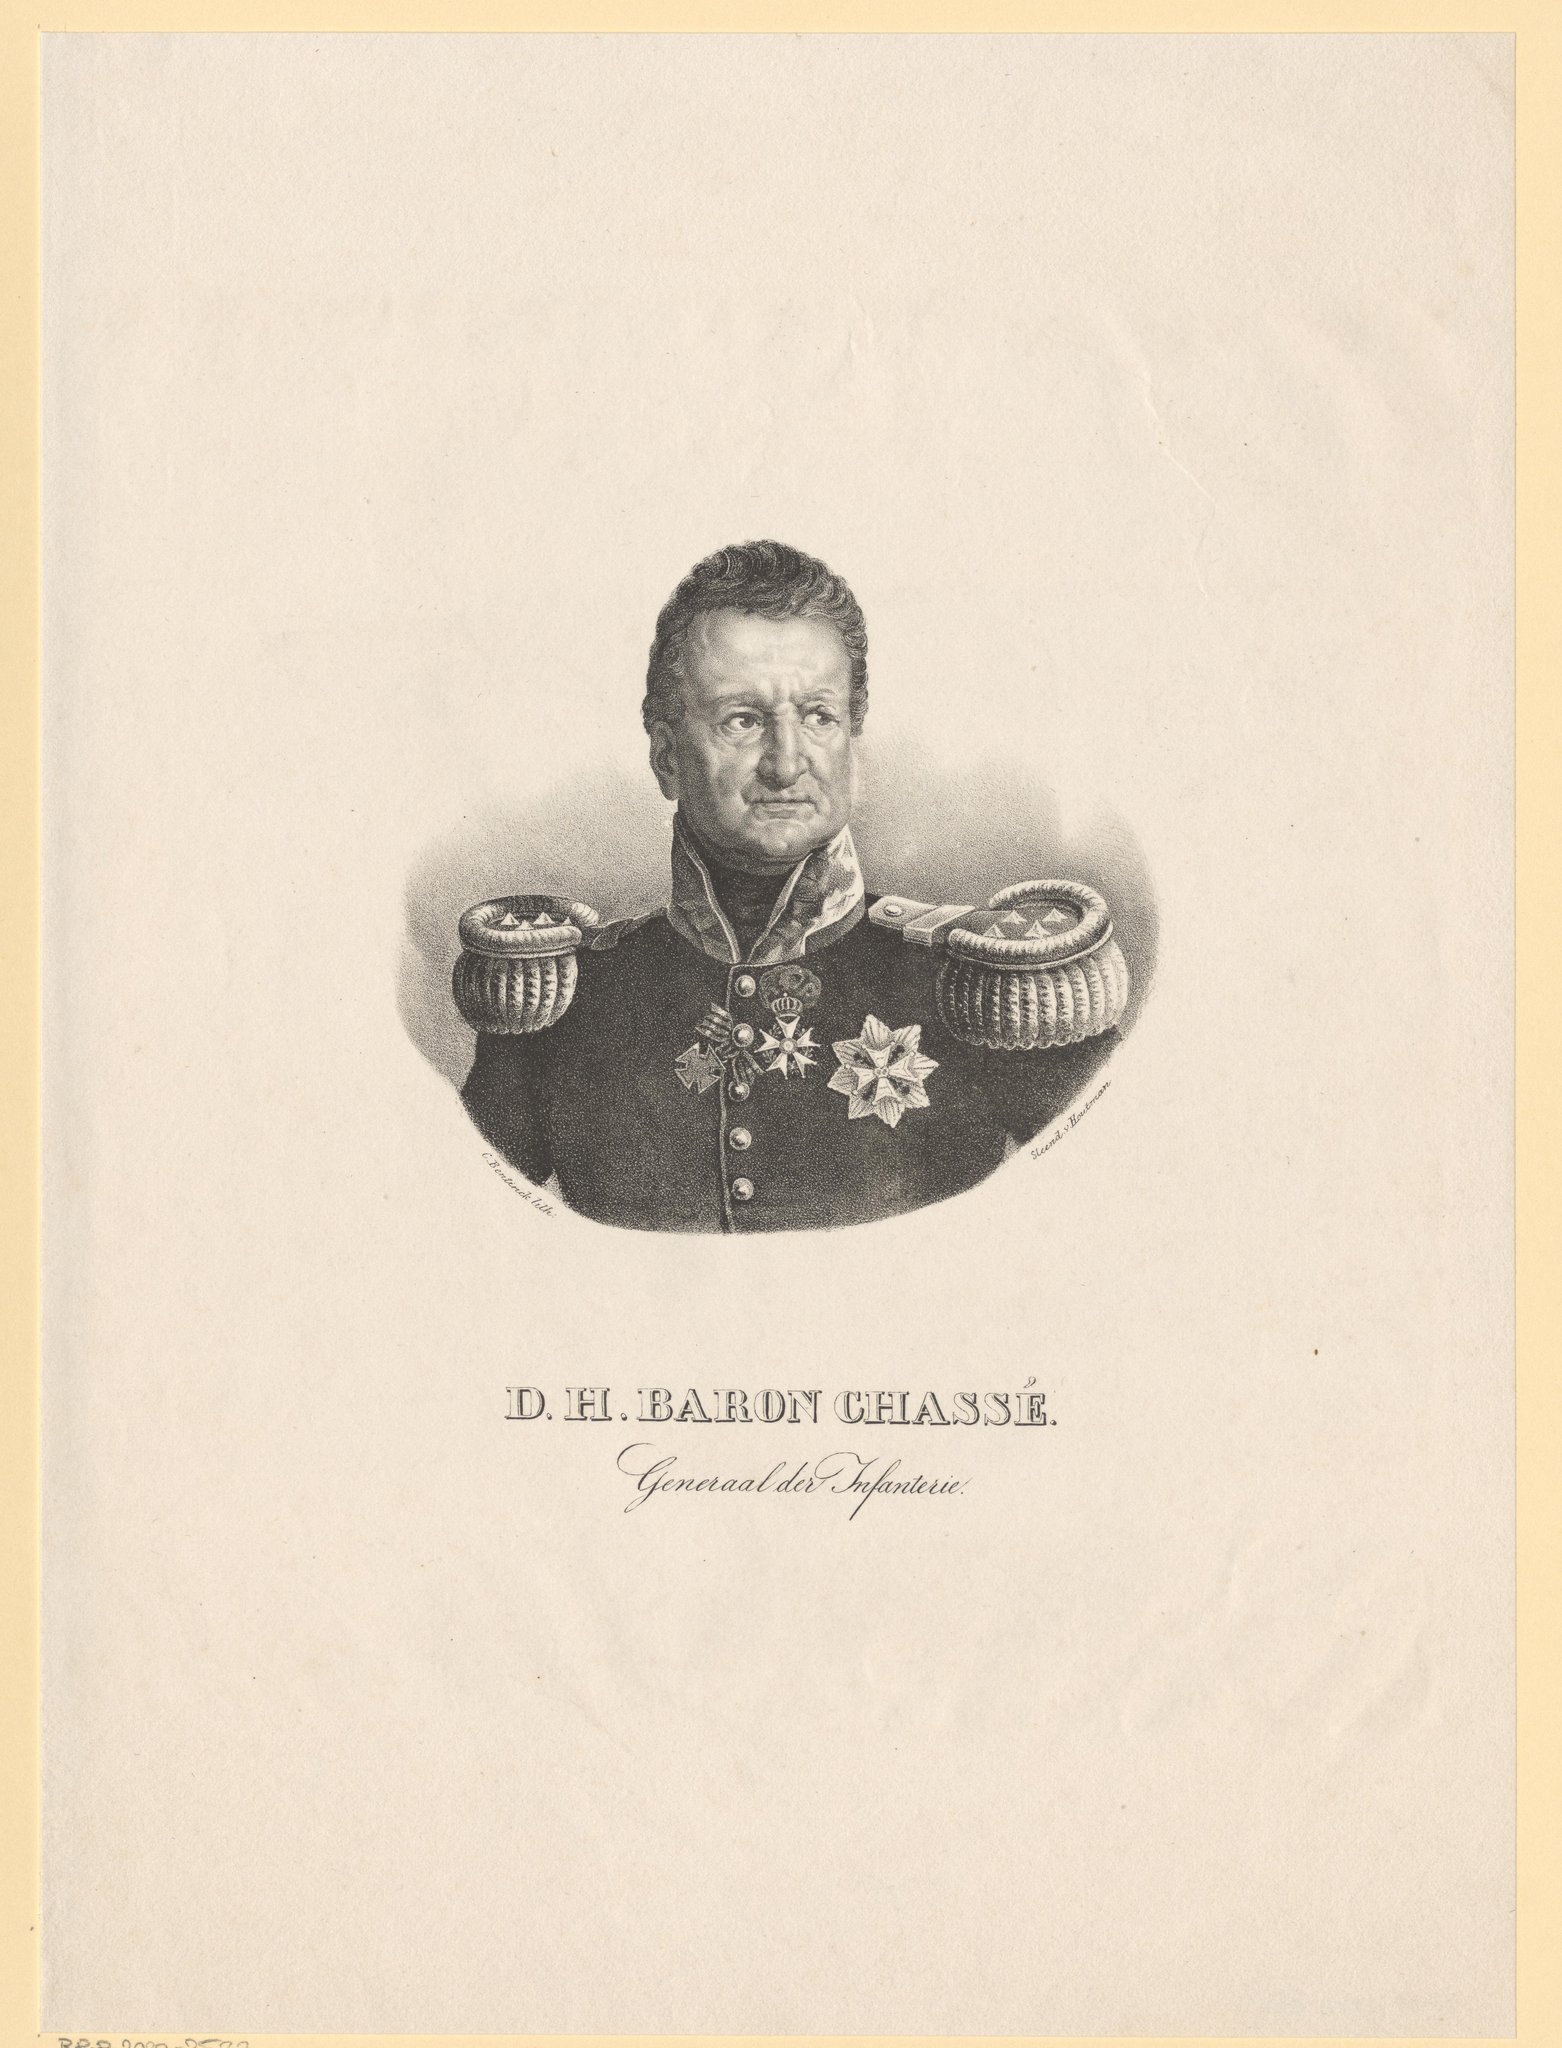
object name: print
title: Portret van David Hendrik baron Chassé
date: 1826-1843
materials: paper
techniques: lithograph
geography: the hague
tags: david hendrik baron chassé, commander-in-chief, general, marshal, historical persons